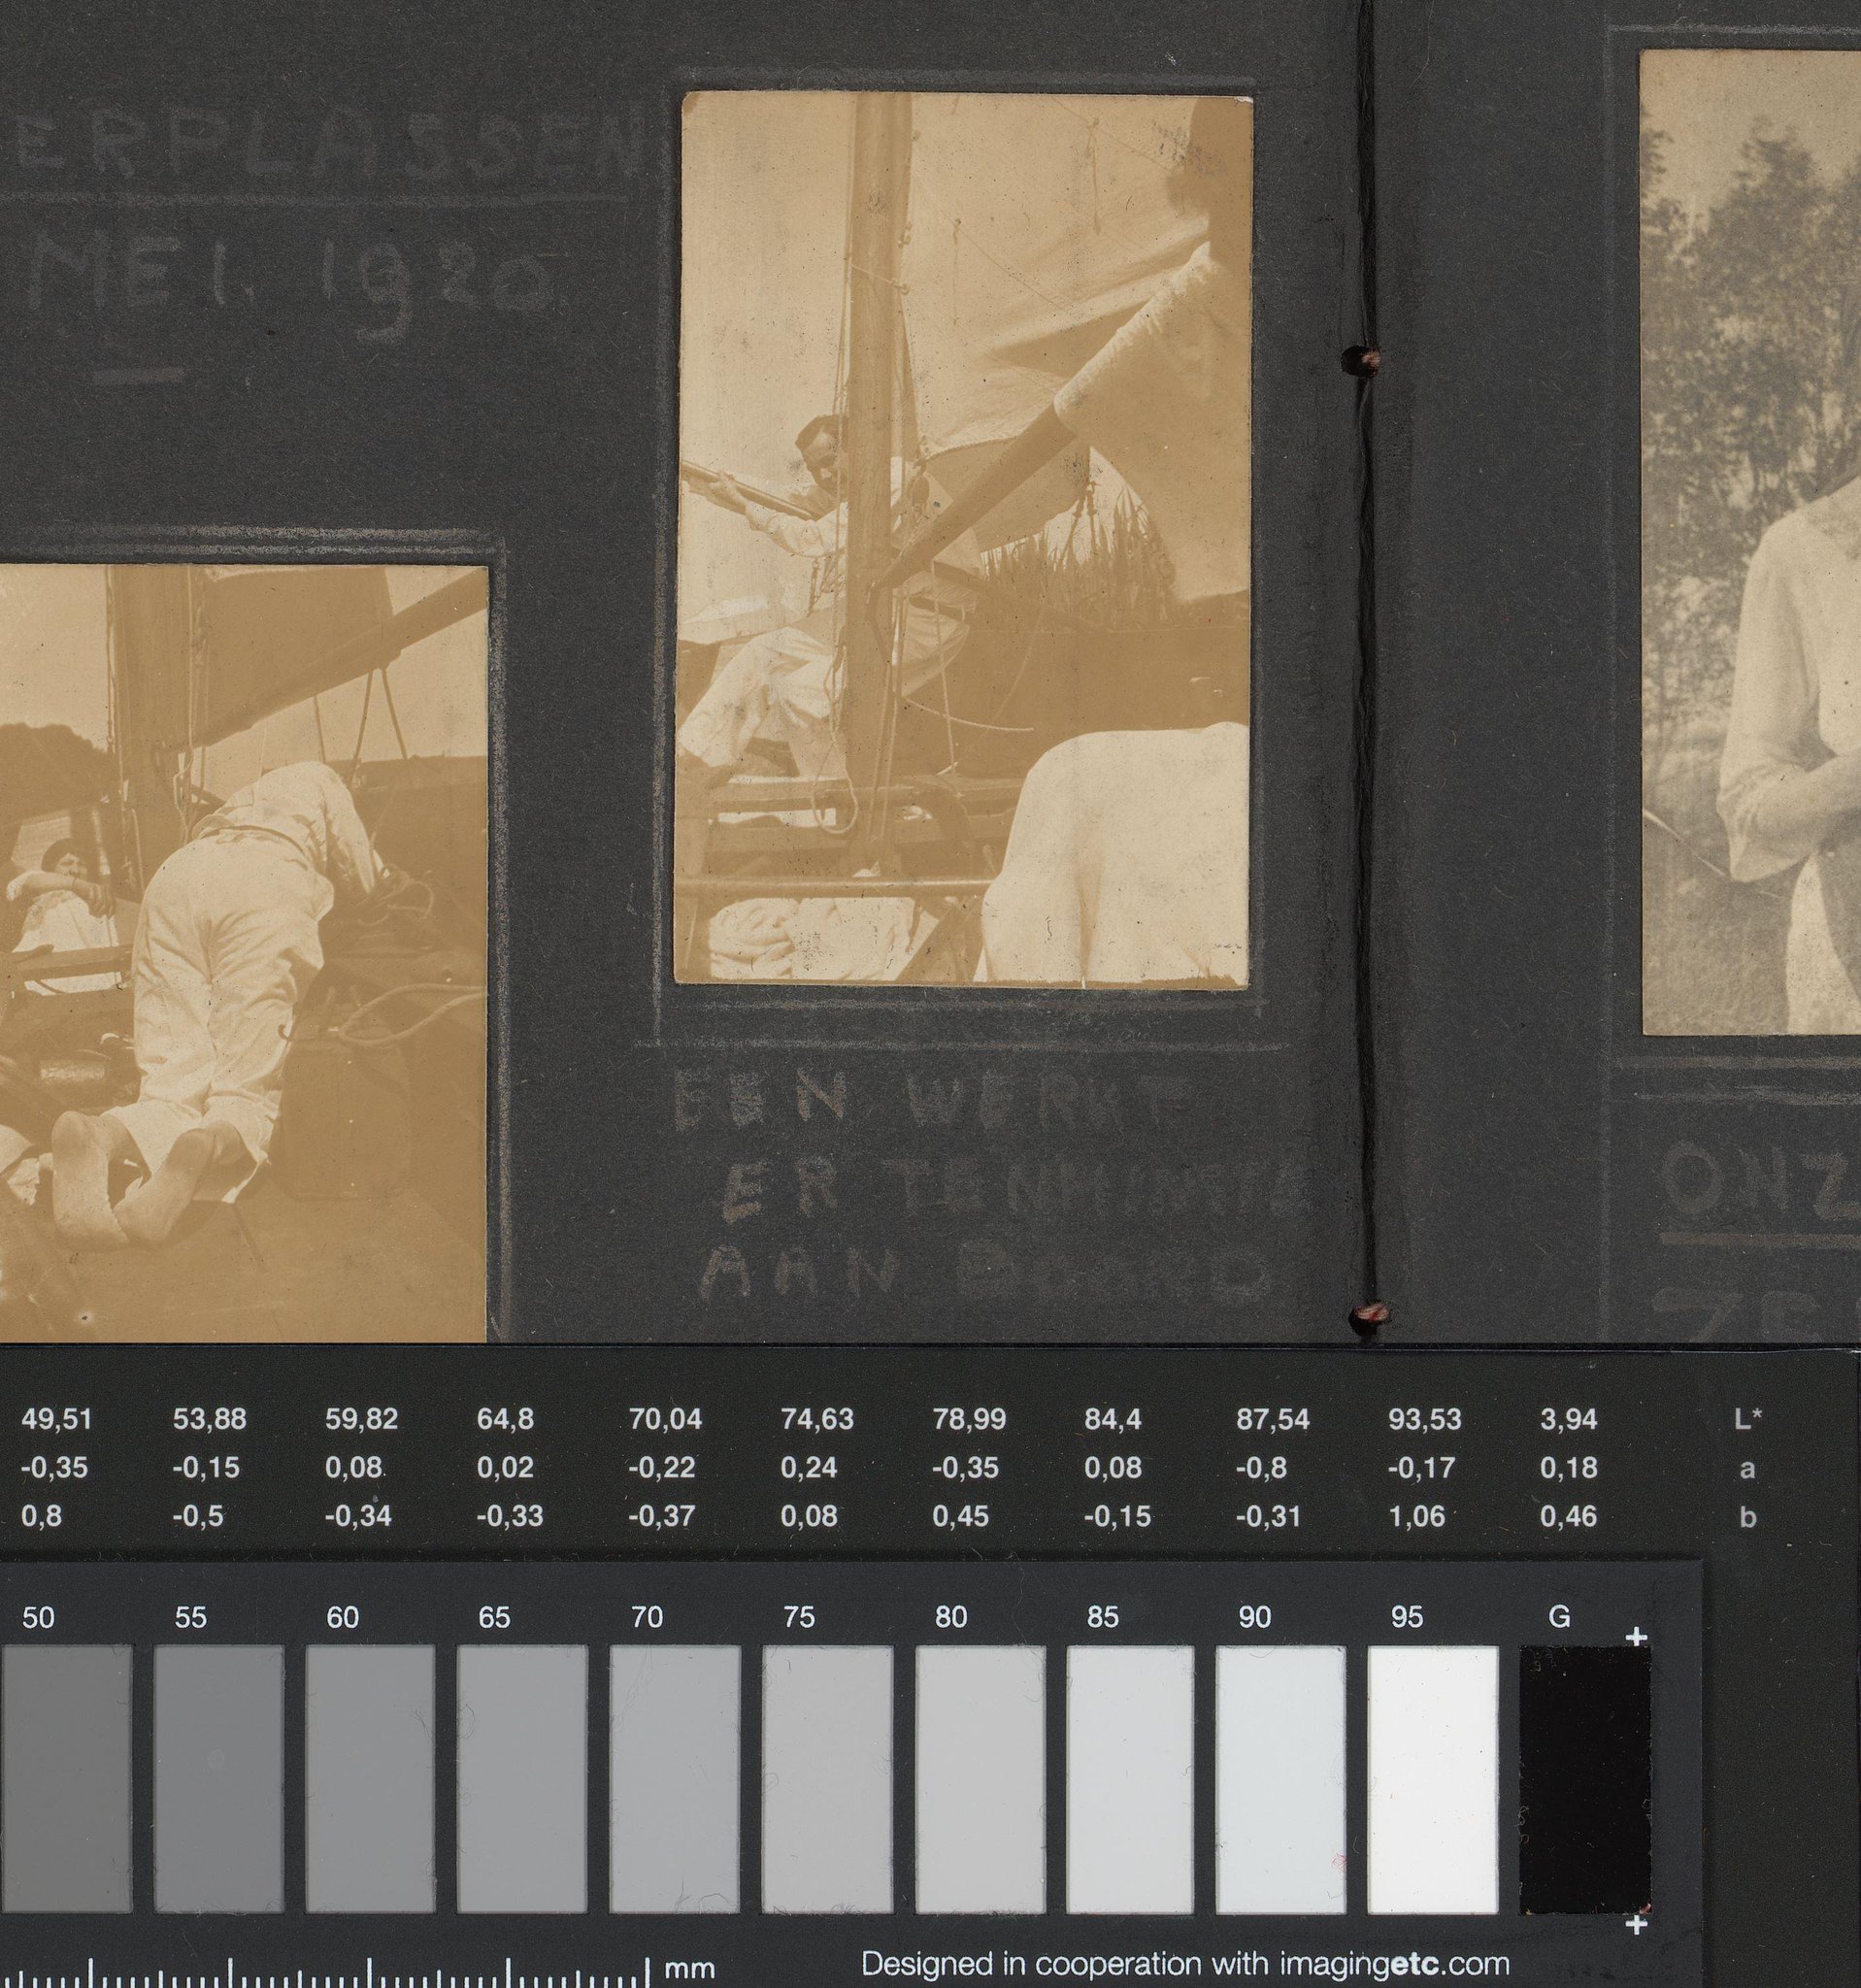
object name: photograph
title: Man op een zeilboot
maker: Anonymous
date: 1920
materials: paper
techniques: gelatin silver print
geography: south holland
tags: sailing-ship, sailing-boat, adult man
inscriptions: inscription: ‘Kagerplassen mei 1920’